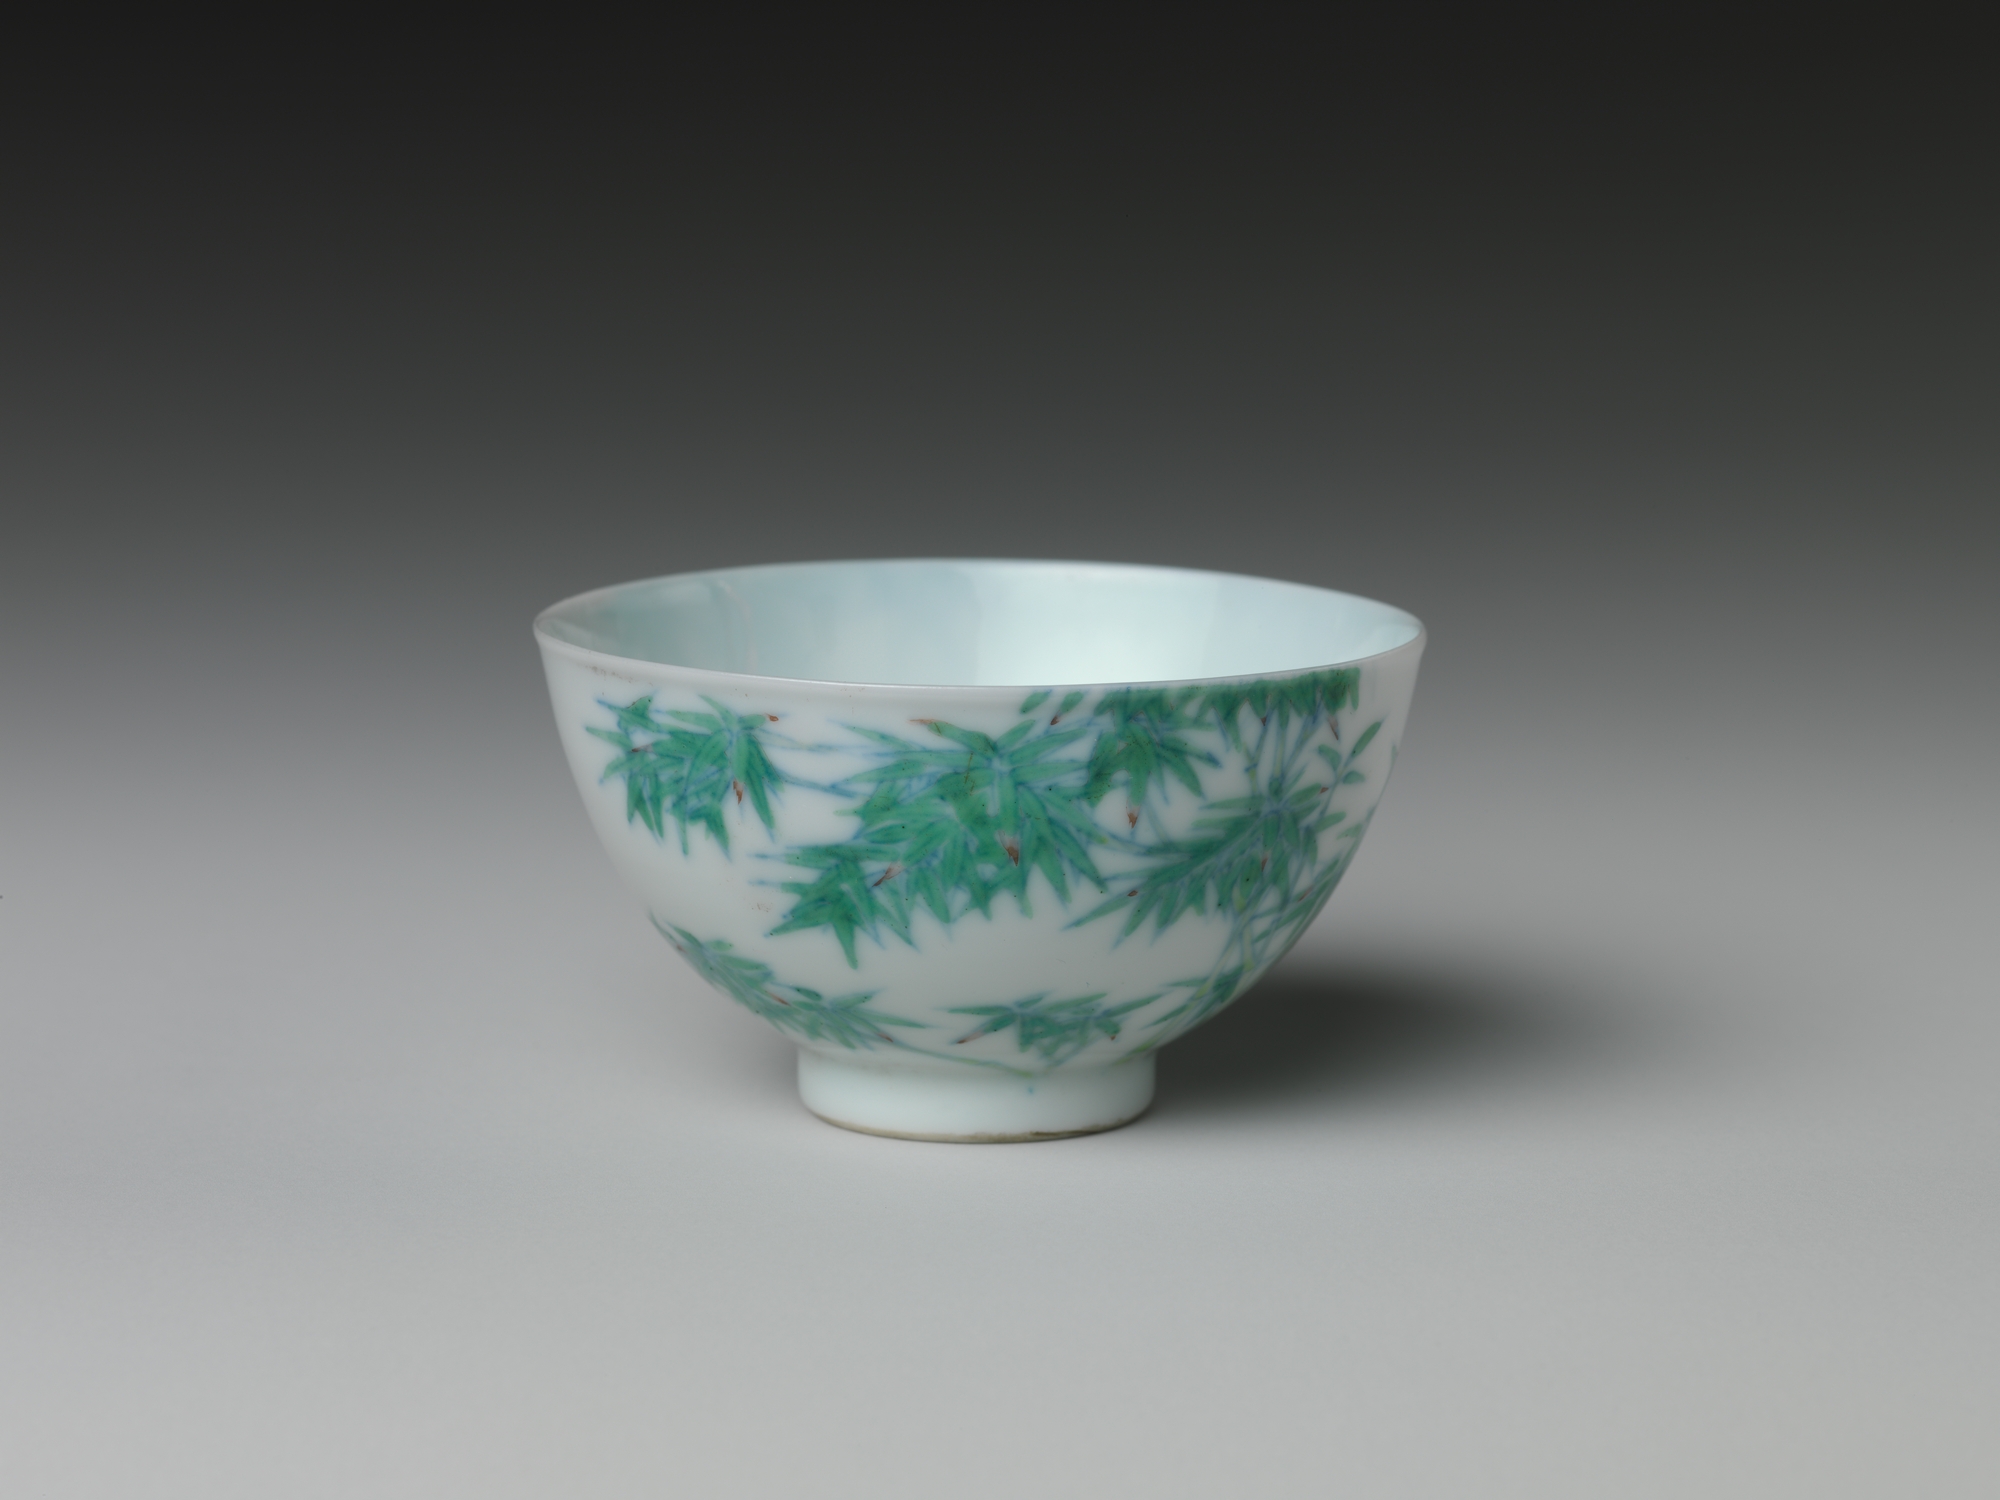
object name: cup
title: Wine Cup with Bamboo (one of a pair)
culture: chinese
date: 1723-1735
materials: cobalt, enamel, glaze, porcelain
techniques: painting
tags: bamboo